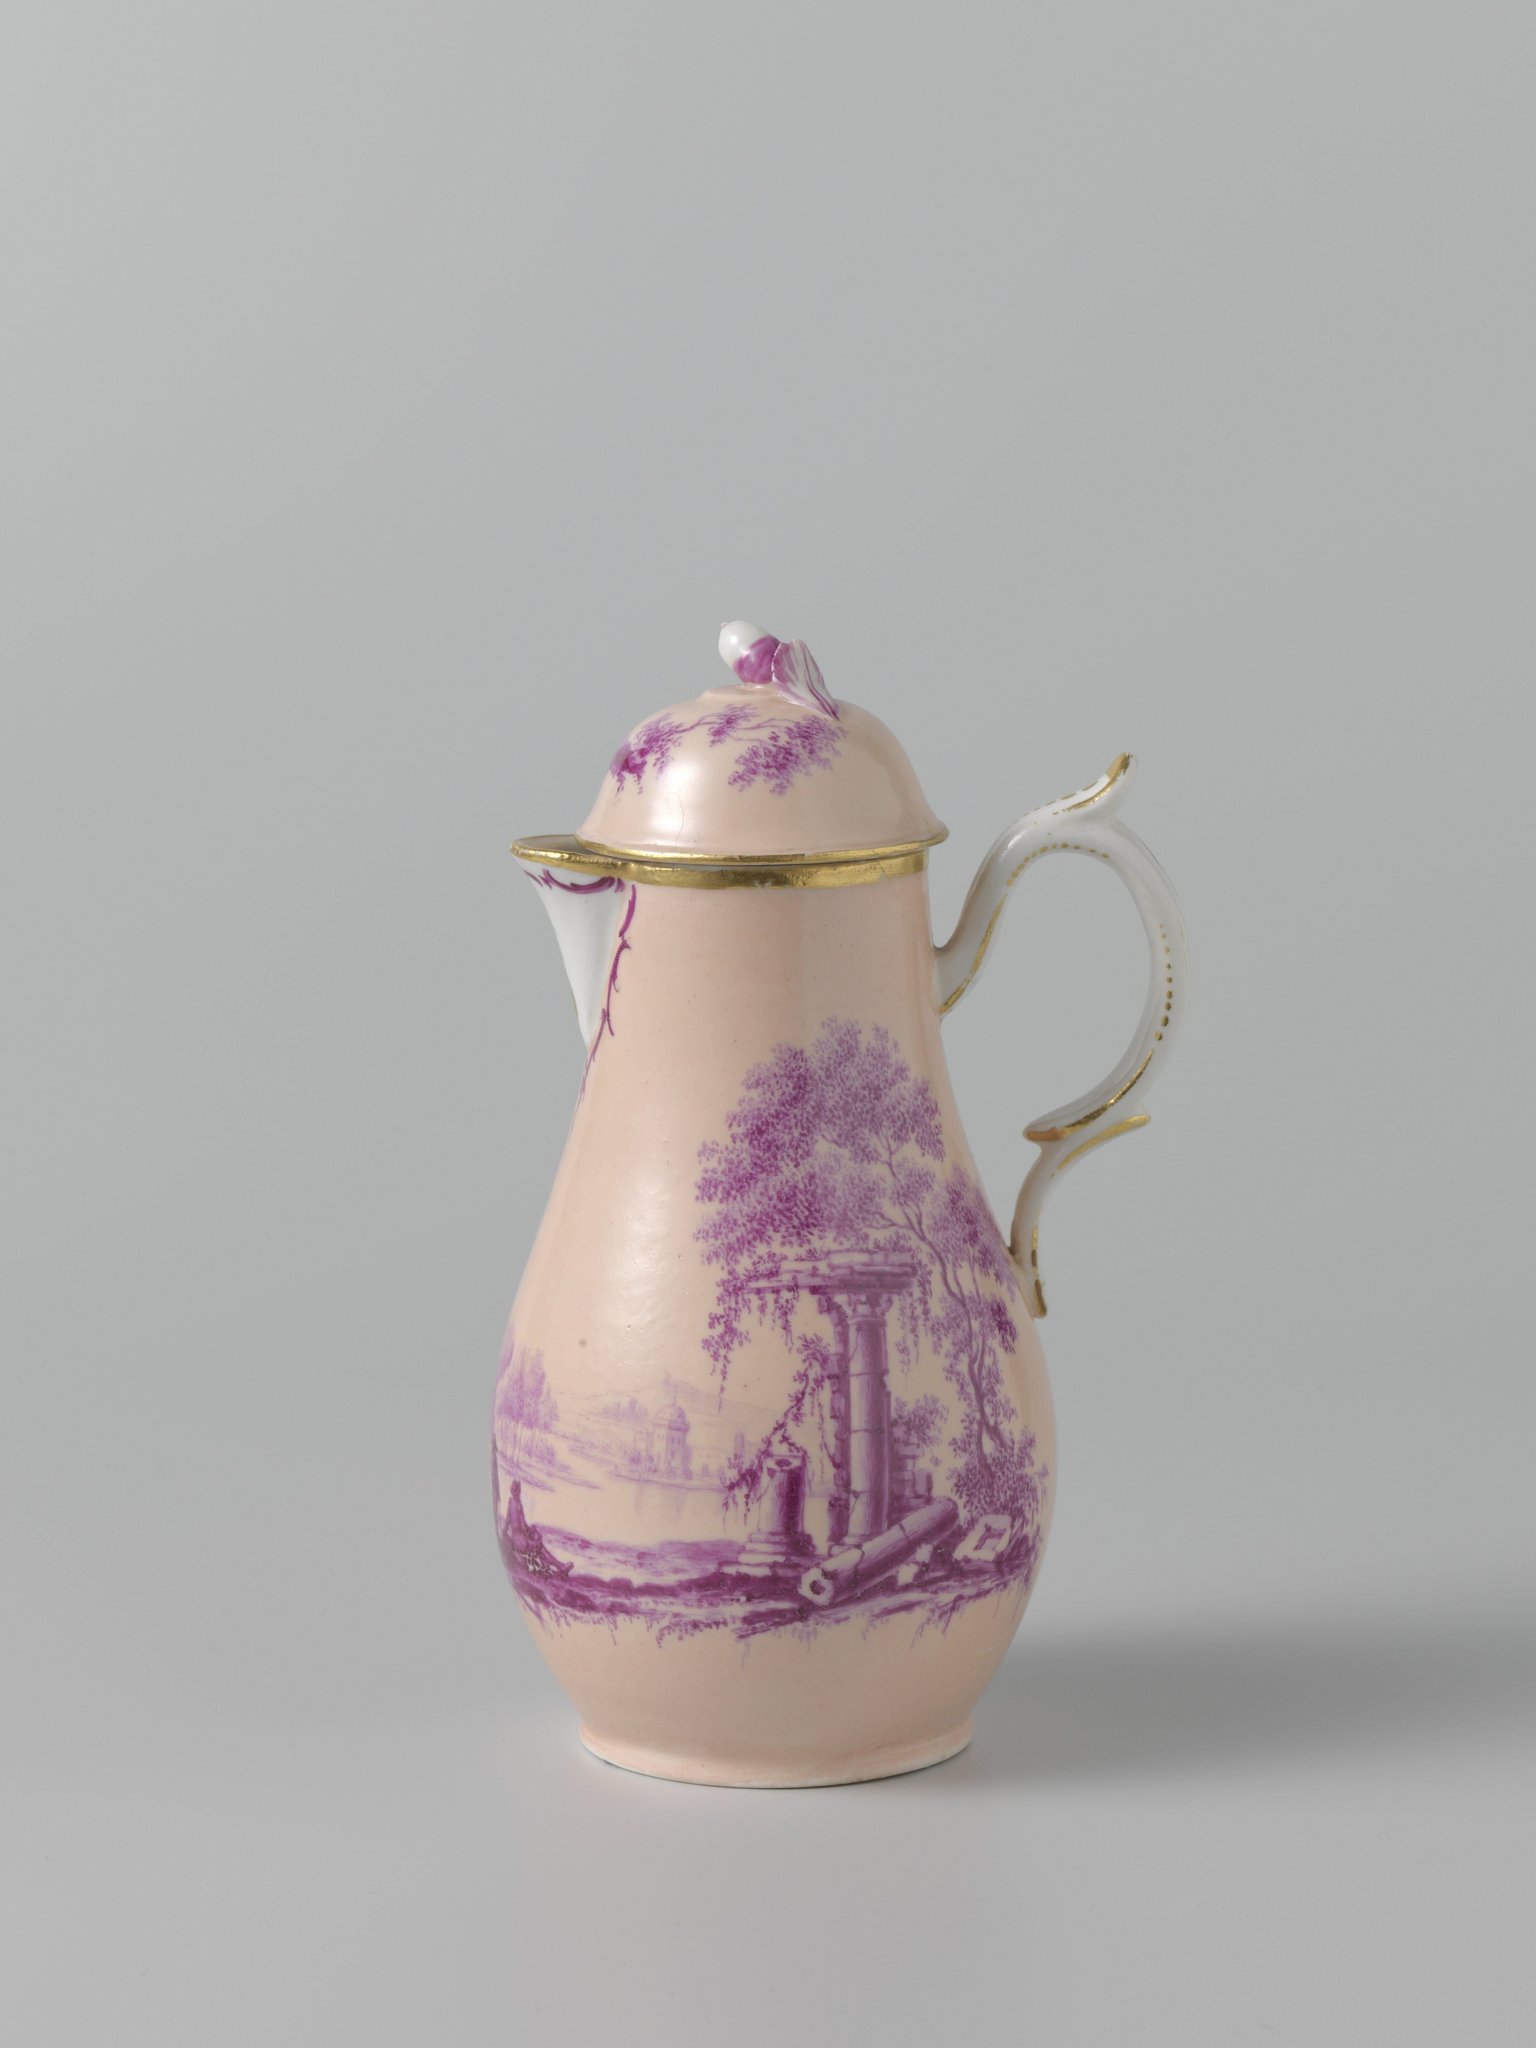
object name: milk jug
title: Part of a coffee and tea service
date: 1774-1778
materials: porcelain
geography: loosdrecht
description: attributed to the Manufactuur Oud-Loosdrecht Loosdrecht, c. 1774–1778 hard-paste porcelain